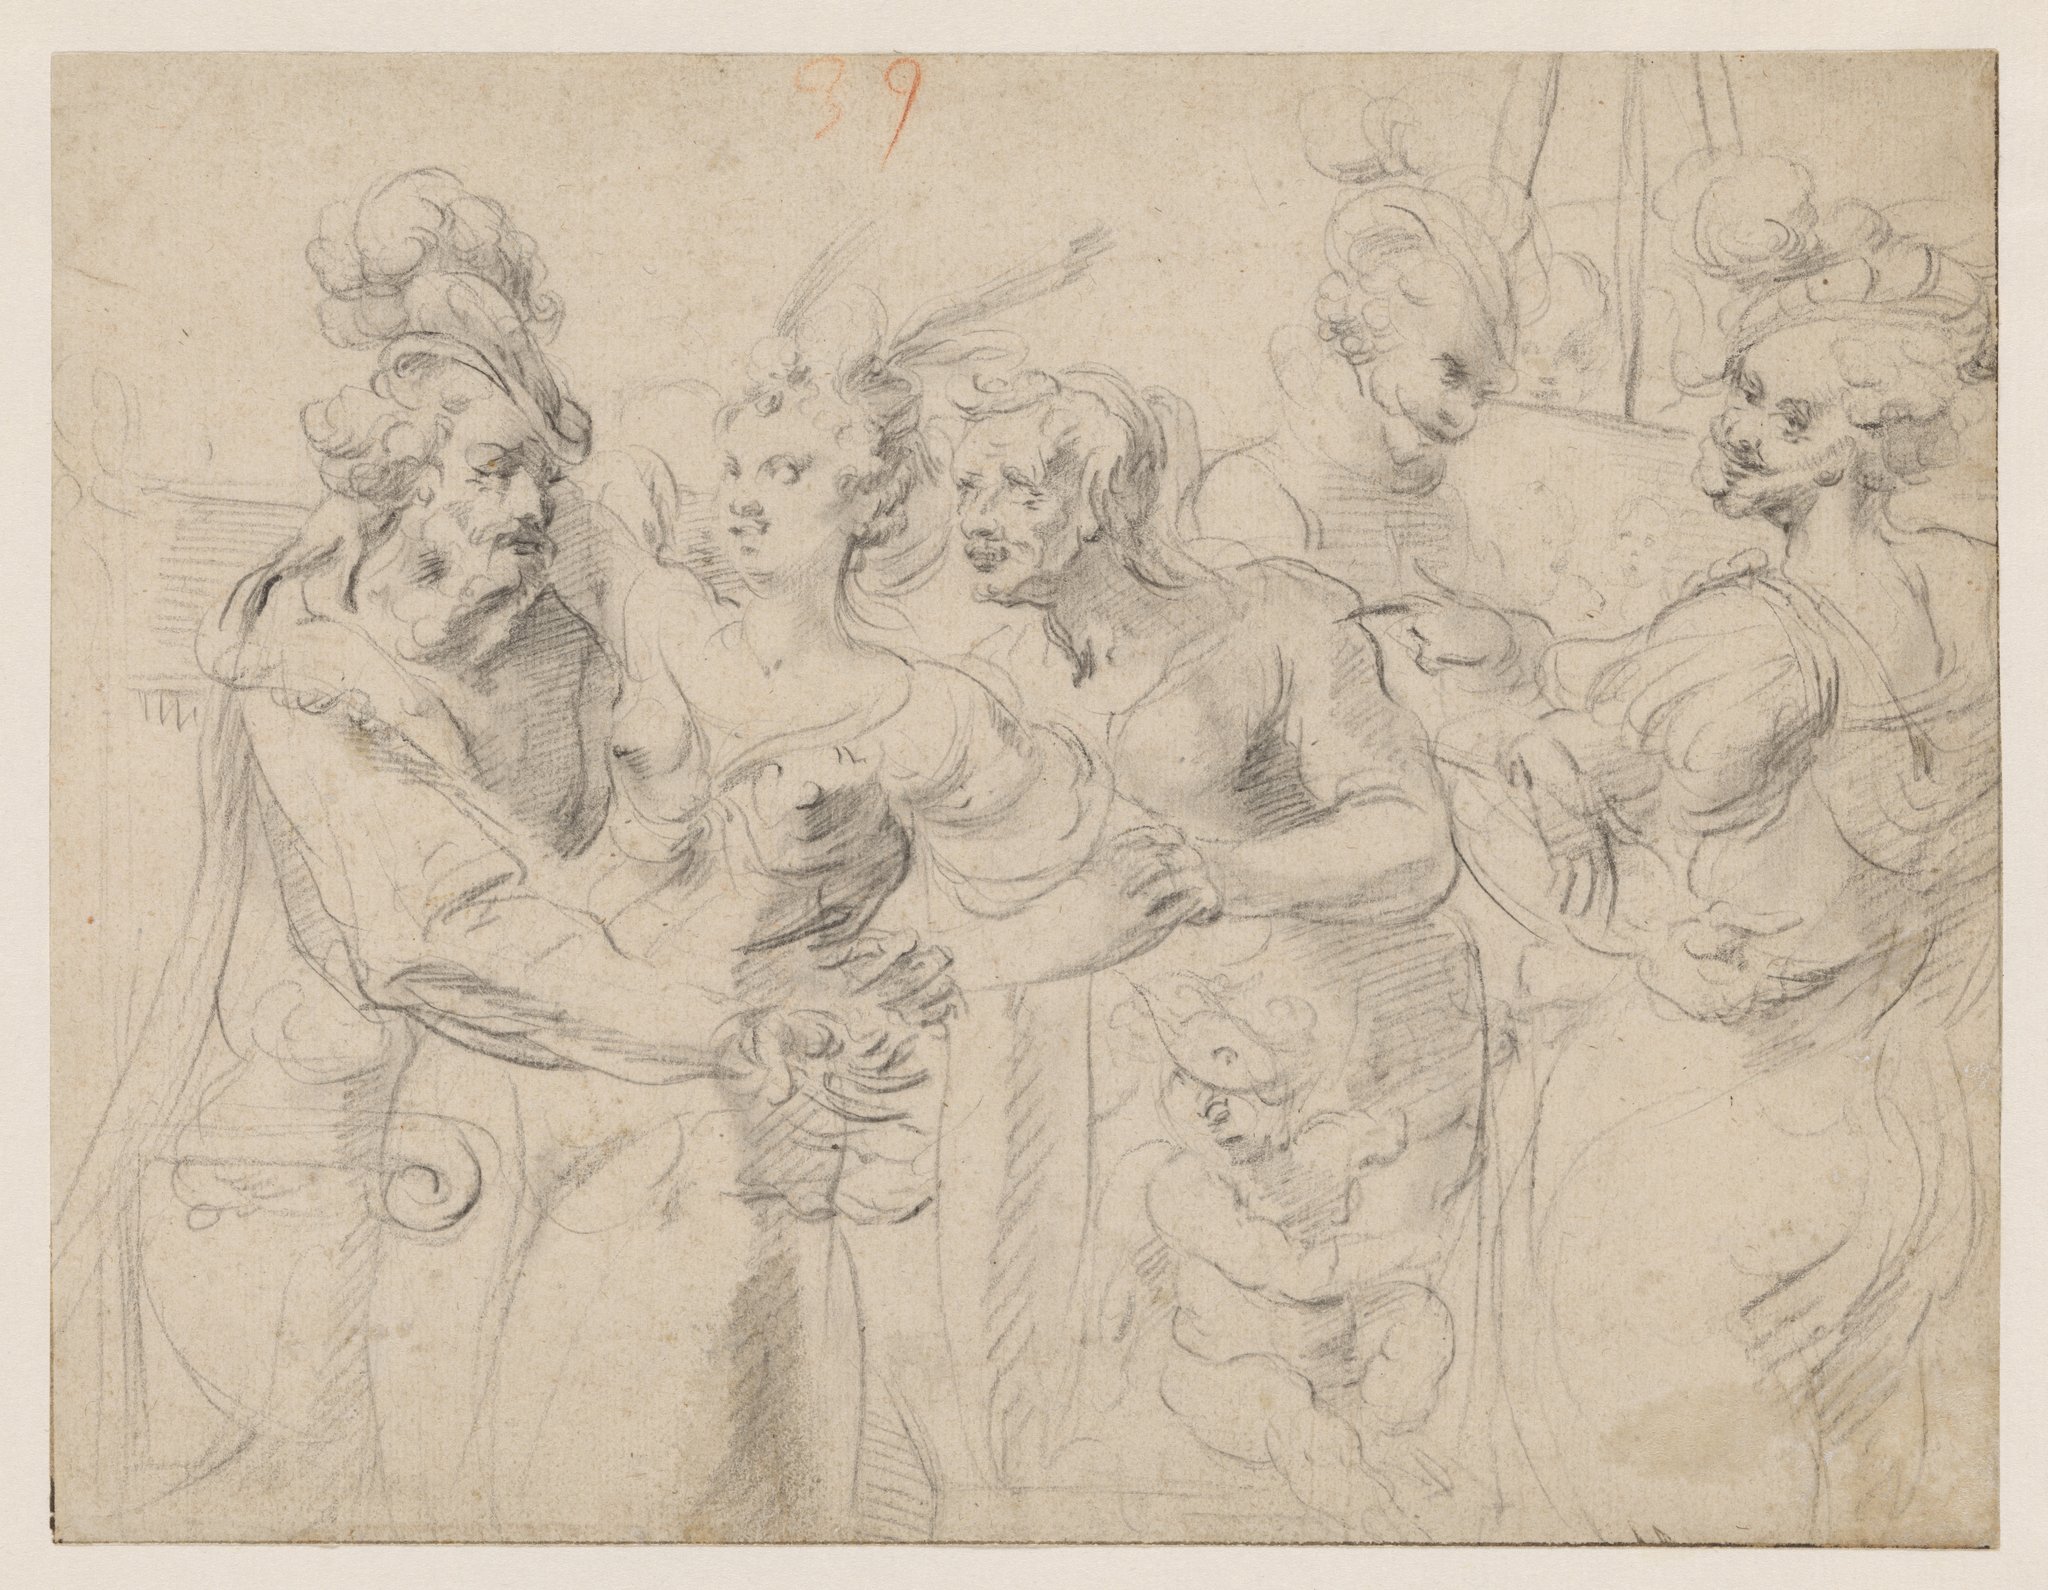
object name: drawing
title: The Procuress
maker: georges lallemand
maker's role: artist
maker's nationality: french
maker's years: 1575-1636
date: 1620-1629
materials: chalk, paper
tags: men,women